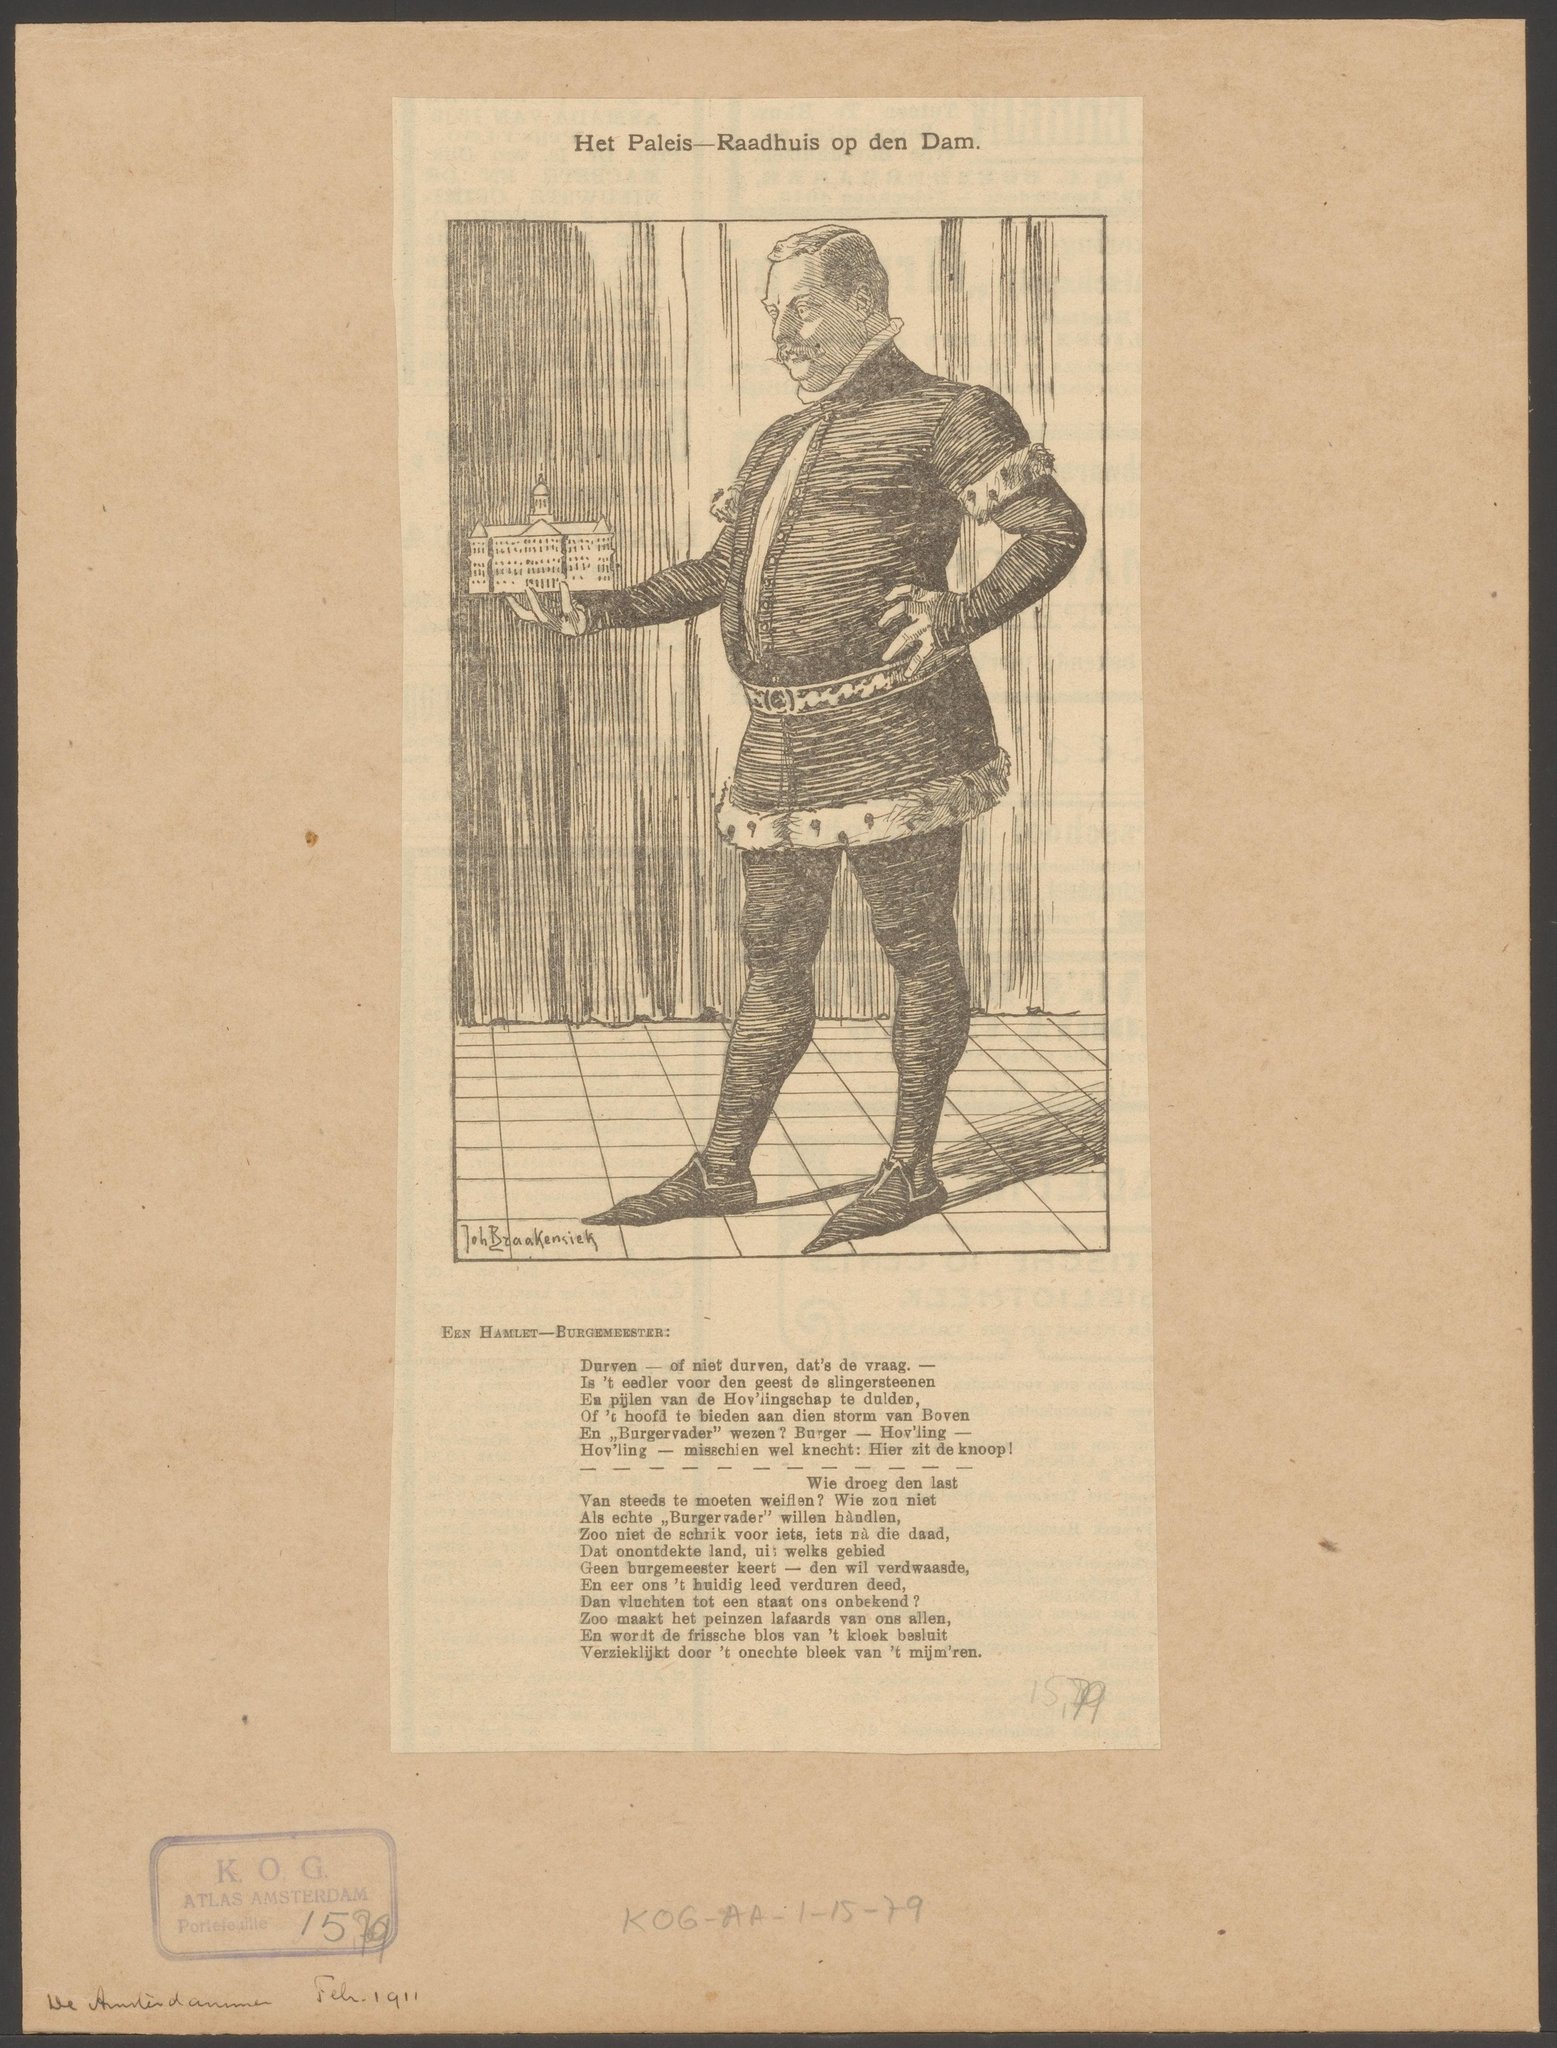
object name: cartoon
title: Het Paleis-Raadhuis op den Dam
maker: johan braakensiek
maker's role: draughtsman, print maker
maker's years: 1858-1940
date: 1902-1911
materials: paper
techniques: letterpress printing, line block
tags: city-view in general; 'veduta', mayor, burgomaster, palace, townhall, royal palace of amsterdam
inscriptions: collector's mark: ‘15,79’ Lugt 1641b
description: Onderwerpsrubriek binnen de Atlas Amsterdam: Nieuwe Stadhuis op de Dam, van buiten, Kleine steentjes kwestie, Paleis - Raadhuiskwestie.